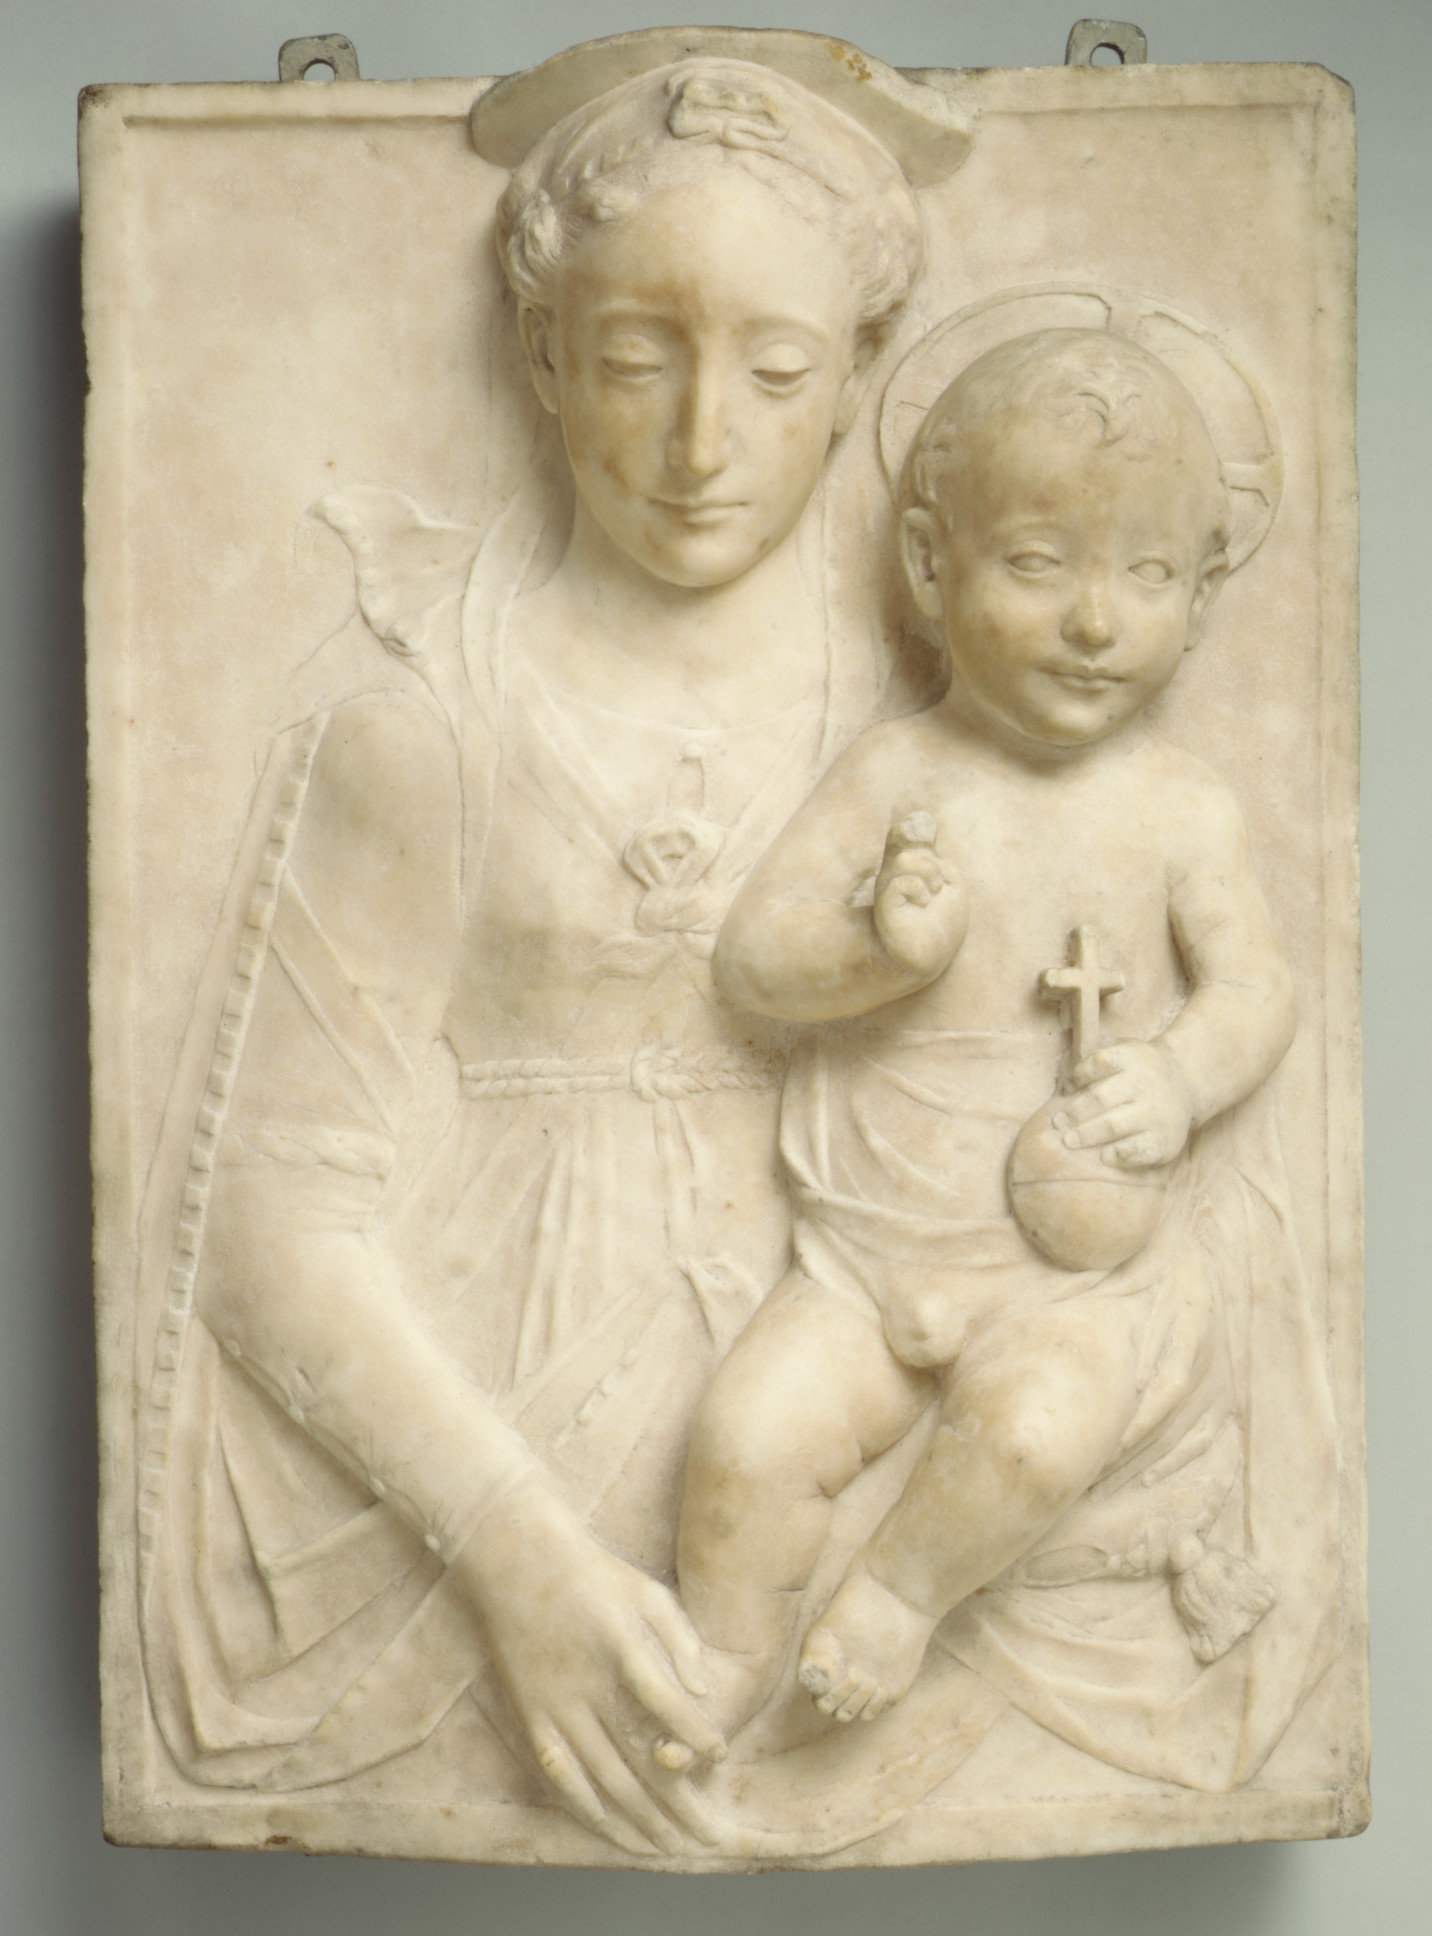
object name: relief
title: Virgin and Child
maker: mino da fiesole (mino di giovanni)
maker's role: artist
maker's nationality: italian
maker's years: 1429-1484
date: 1471-1474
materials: marble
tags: madonna and child,cross